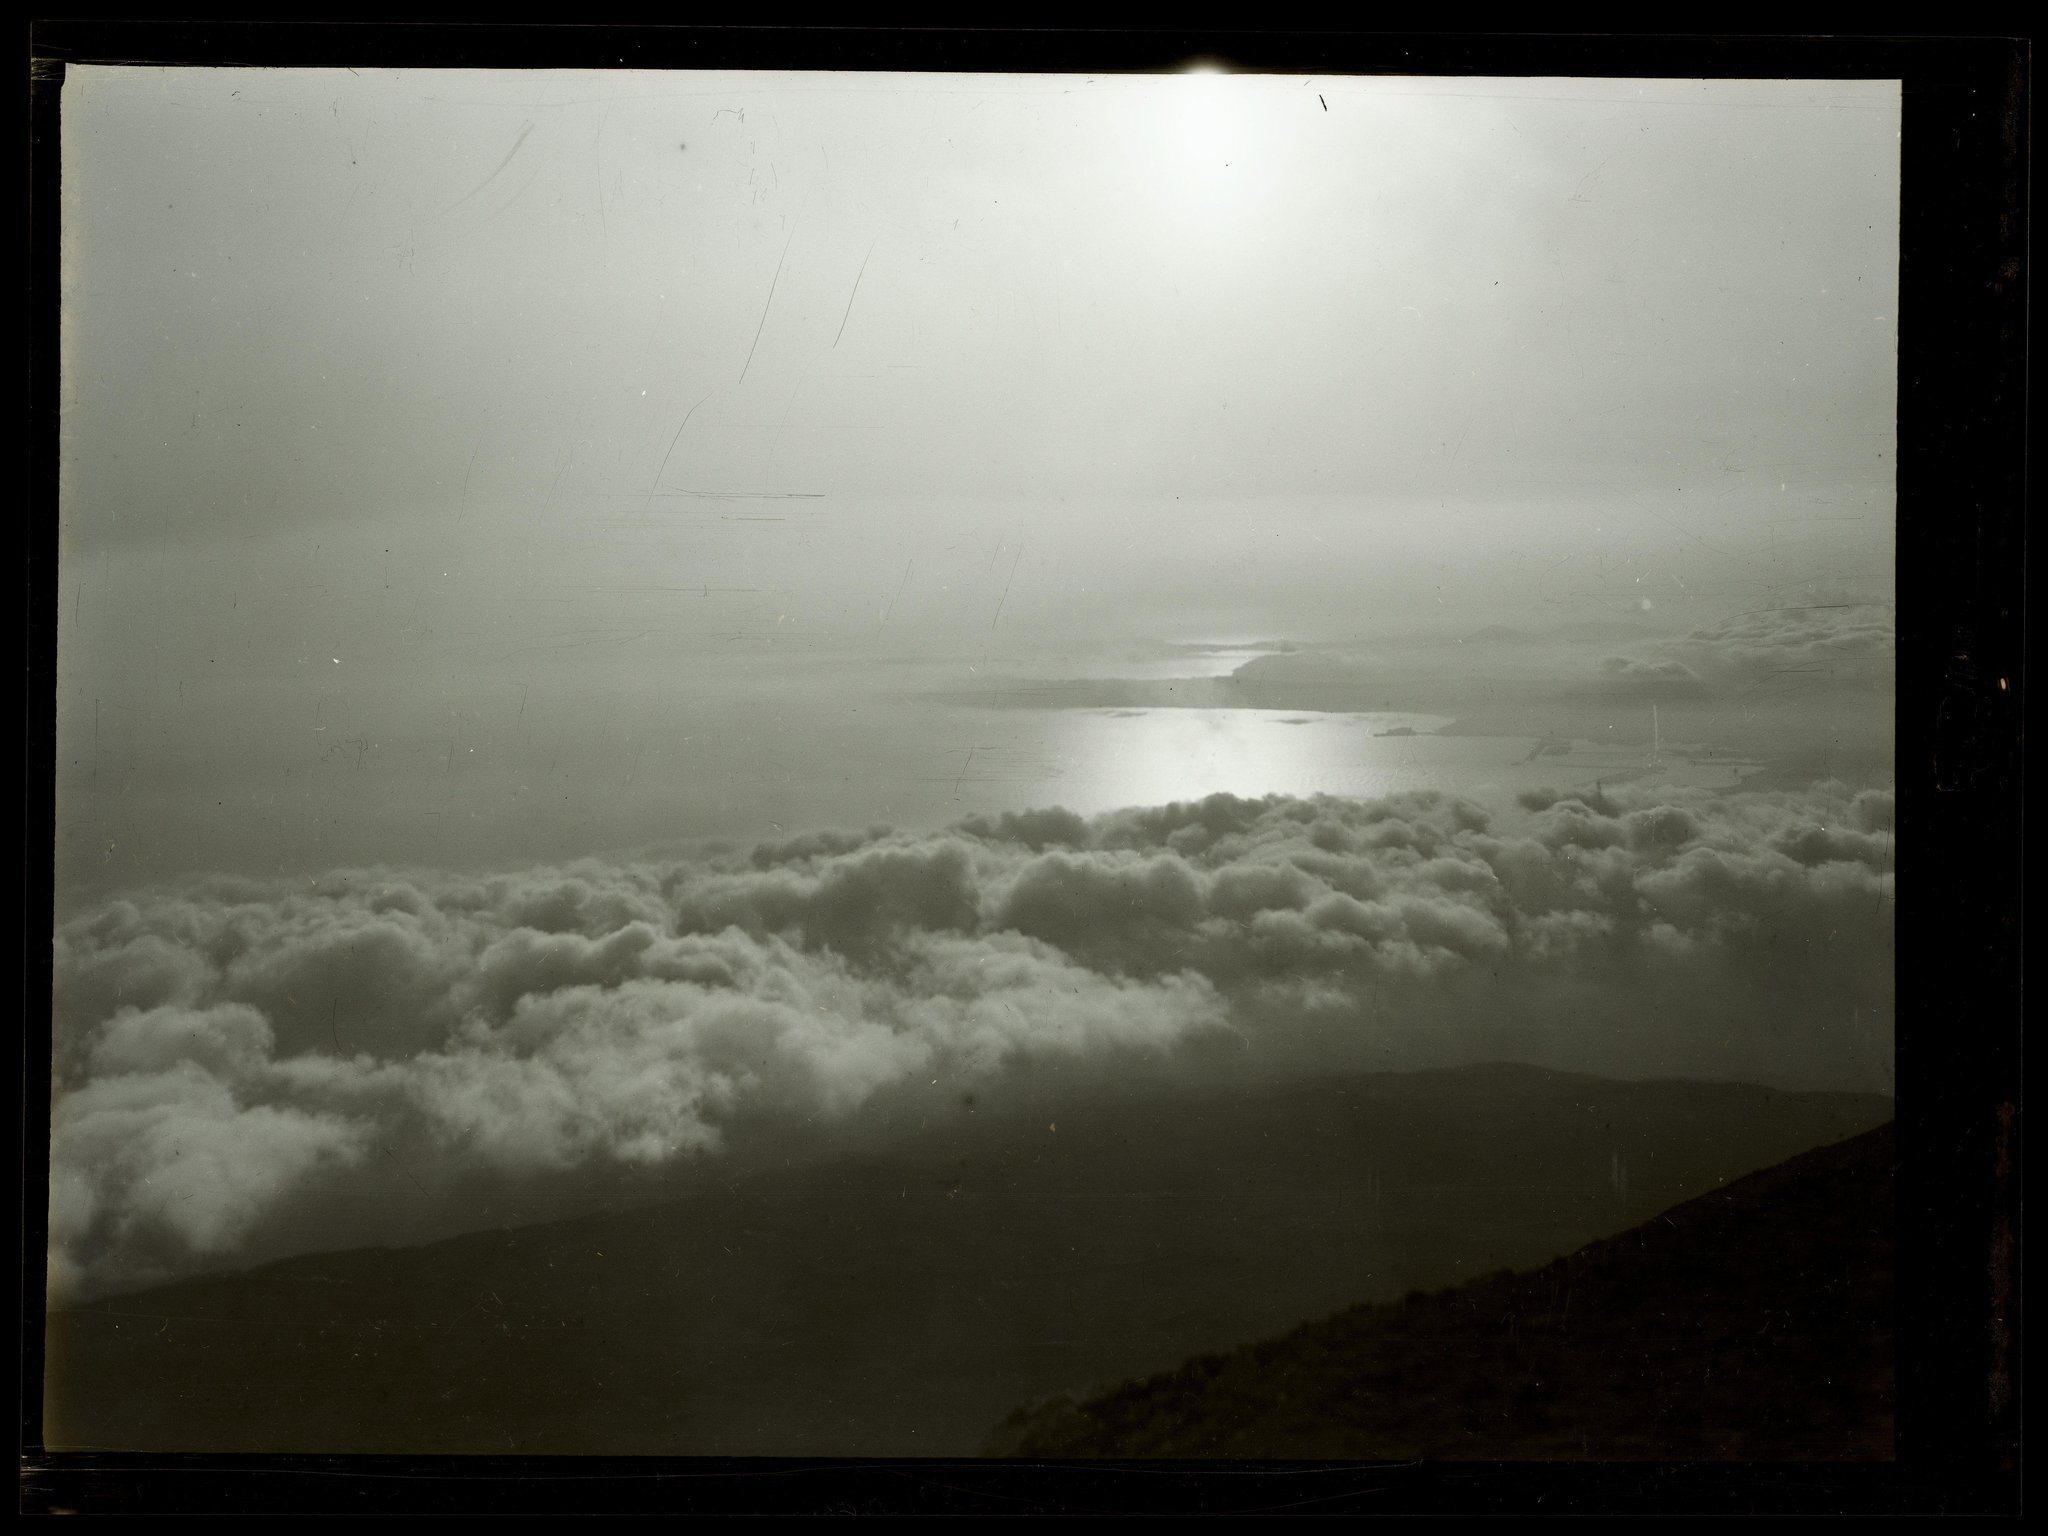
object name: negative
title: Filmnegatief met opname van Napels of omgeving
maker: Anonymous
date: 1907-1935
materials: film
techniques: gelatin silver negative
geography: italy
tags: italy